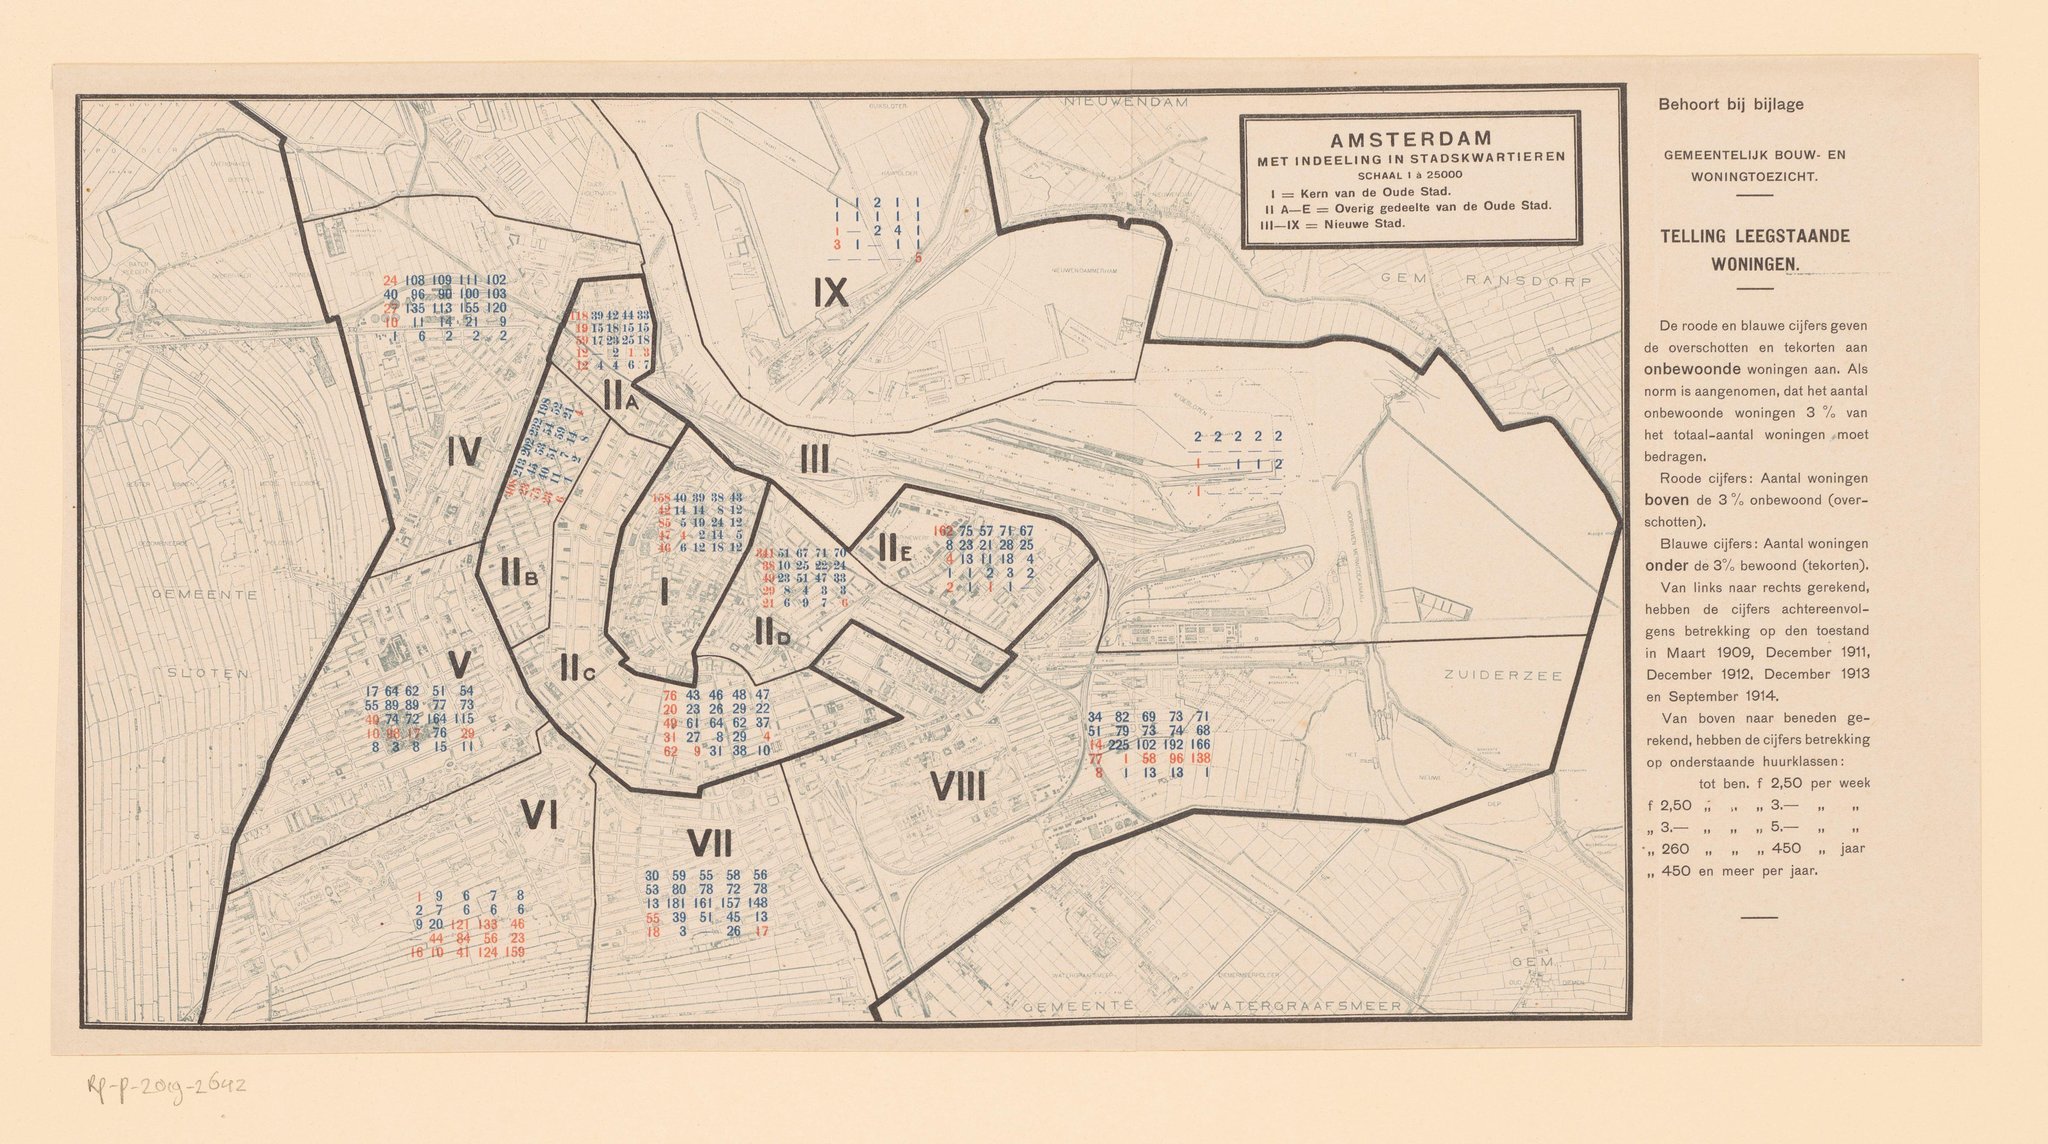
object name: area plan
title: Reproductie van een plattegrond van Amsterdam met de telling van de leegstaande woningen in de stad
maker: Anonymous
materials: paper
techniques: photolithography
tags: maps of cities, amsterdam